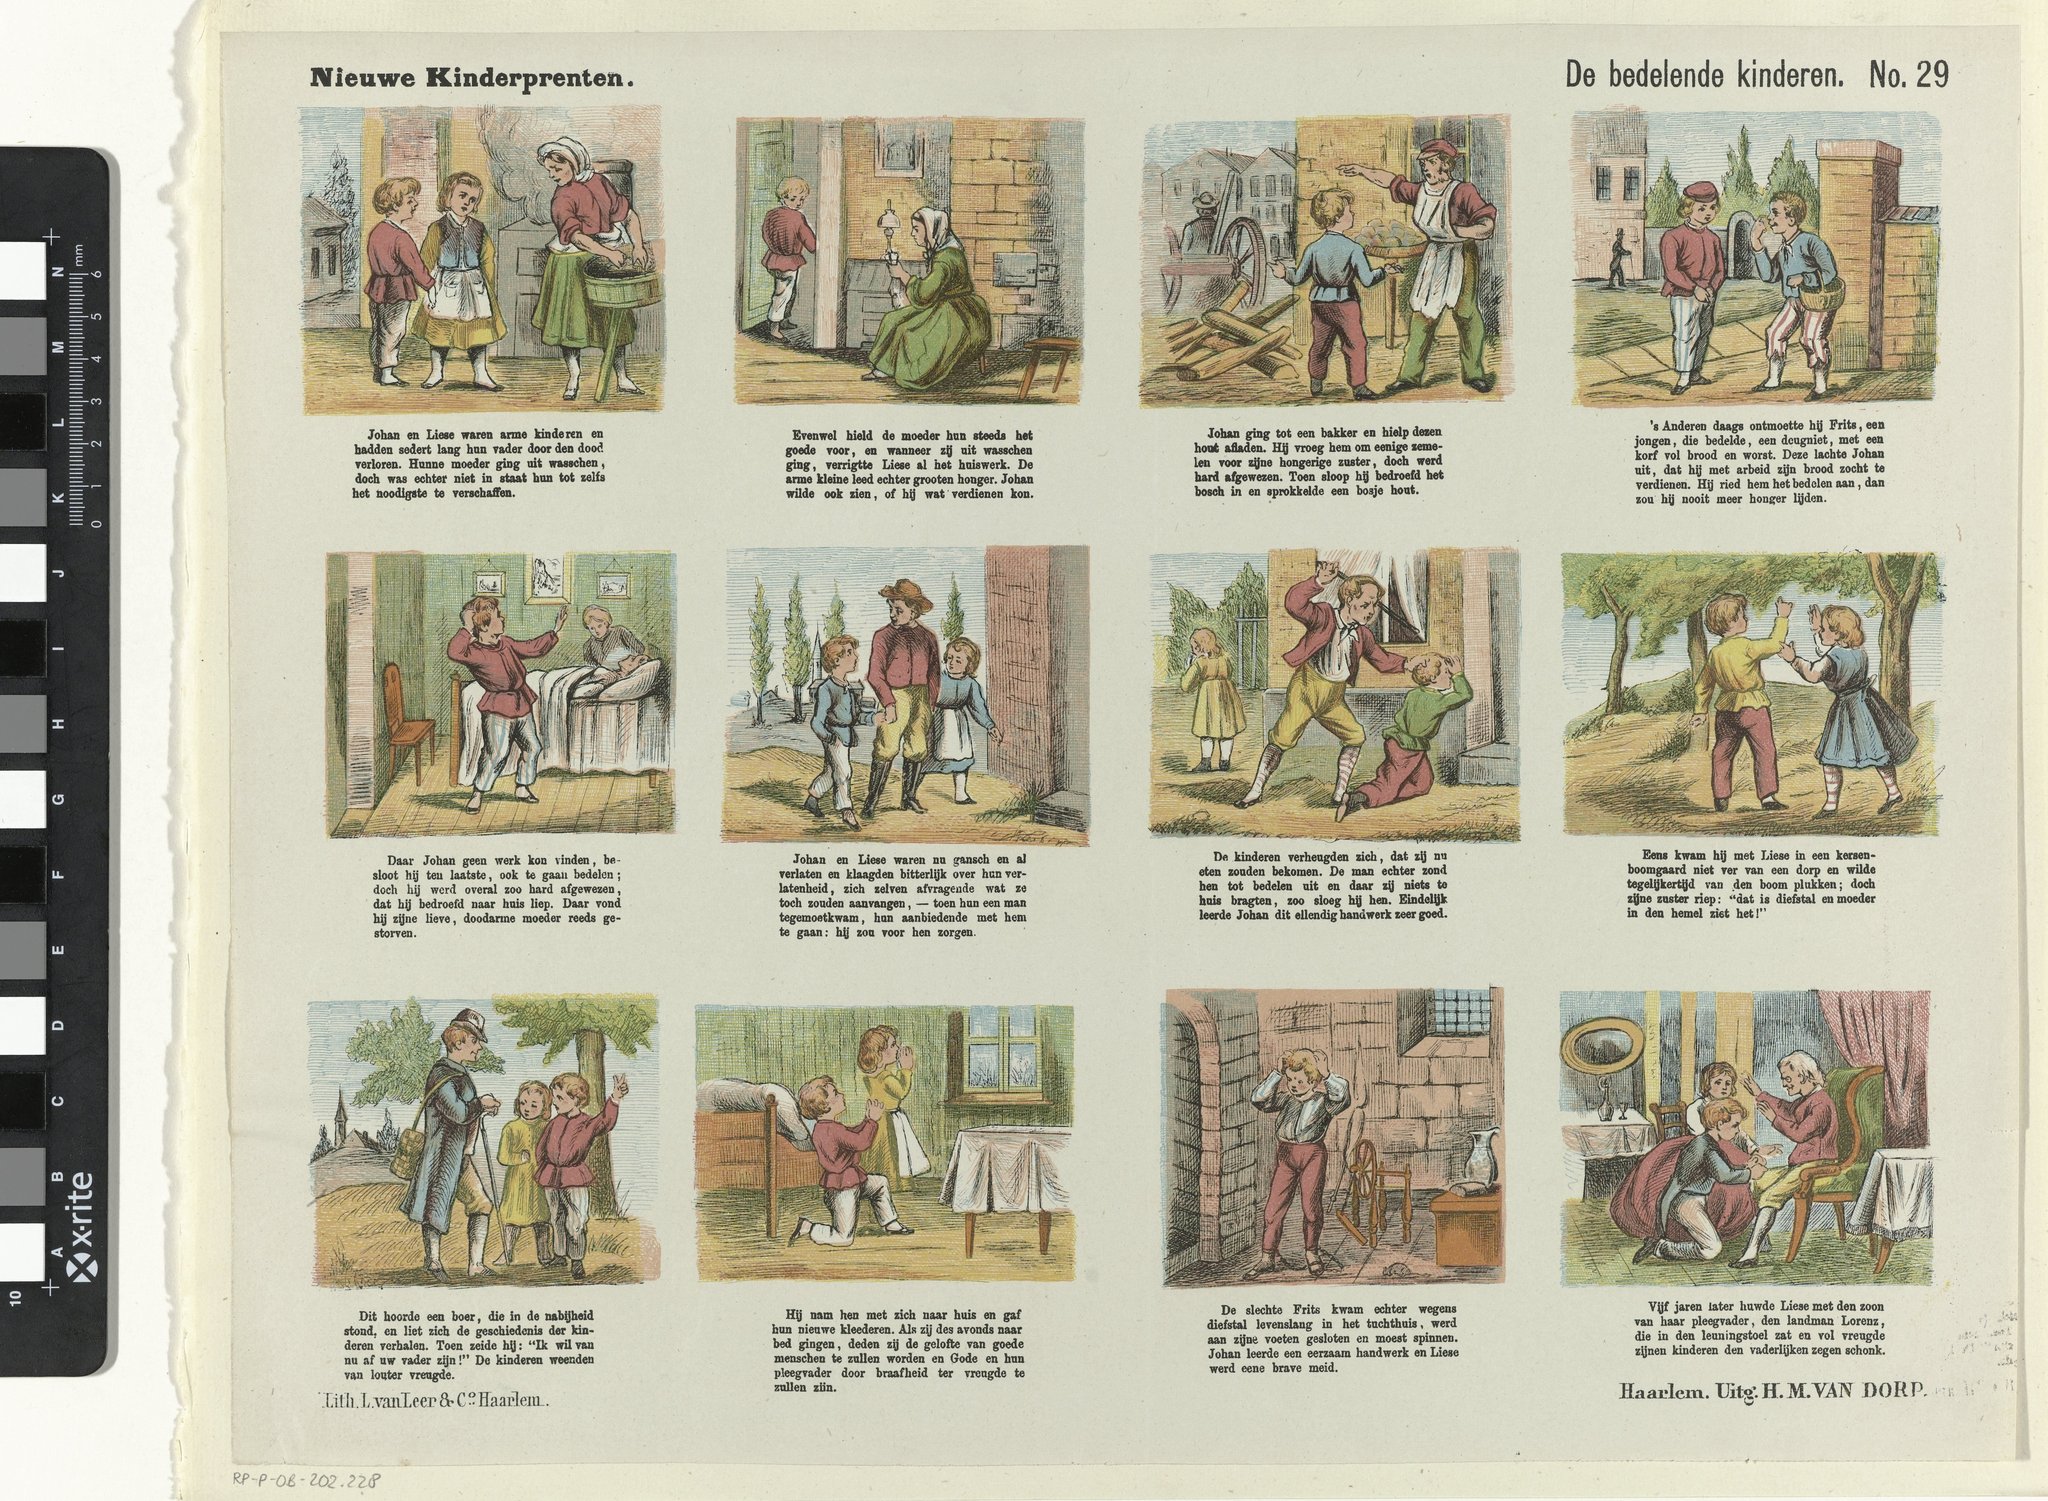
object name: popular print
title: Nieuwe kinderprenten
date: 1872-1883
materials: paper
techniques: lithograph, letterpress printing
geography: haarlem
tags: child, beggar, orphans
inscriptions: collector's mark: Lugt 2760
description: Blad met 12 voorstellingen over weeskinderen die gaan bedelen en in verkeerde handen vallen. Een boer neemt ze als pleegvader op. Onder elke afbeelding een onderschrift. Genummerd rechtsboven: No. 29.